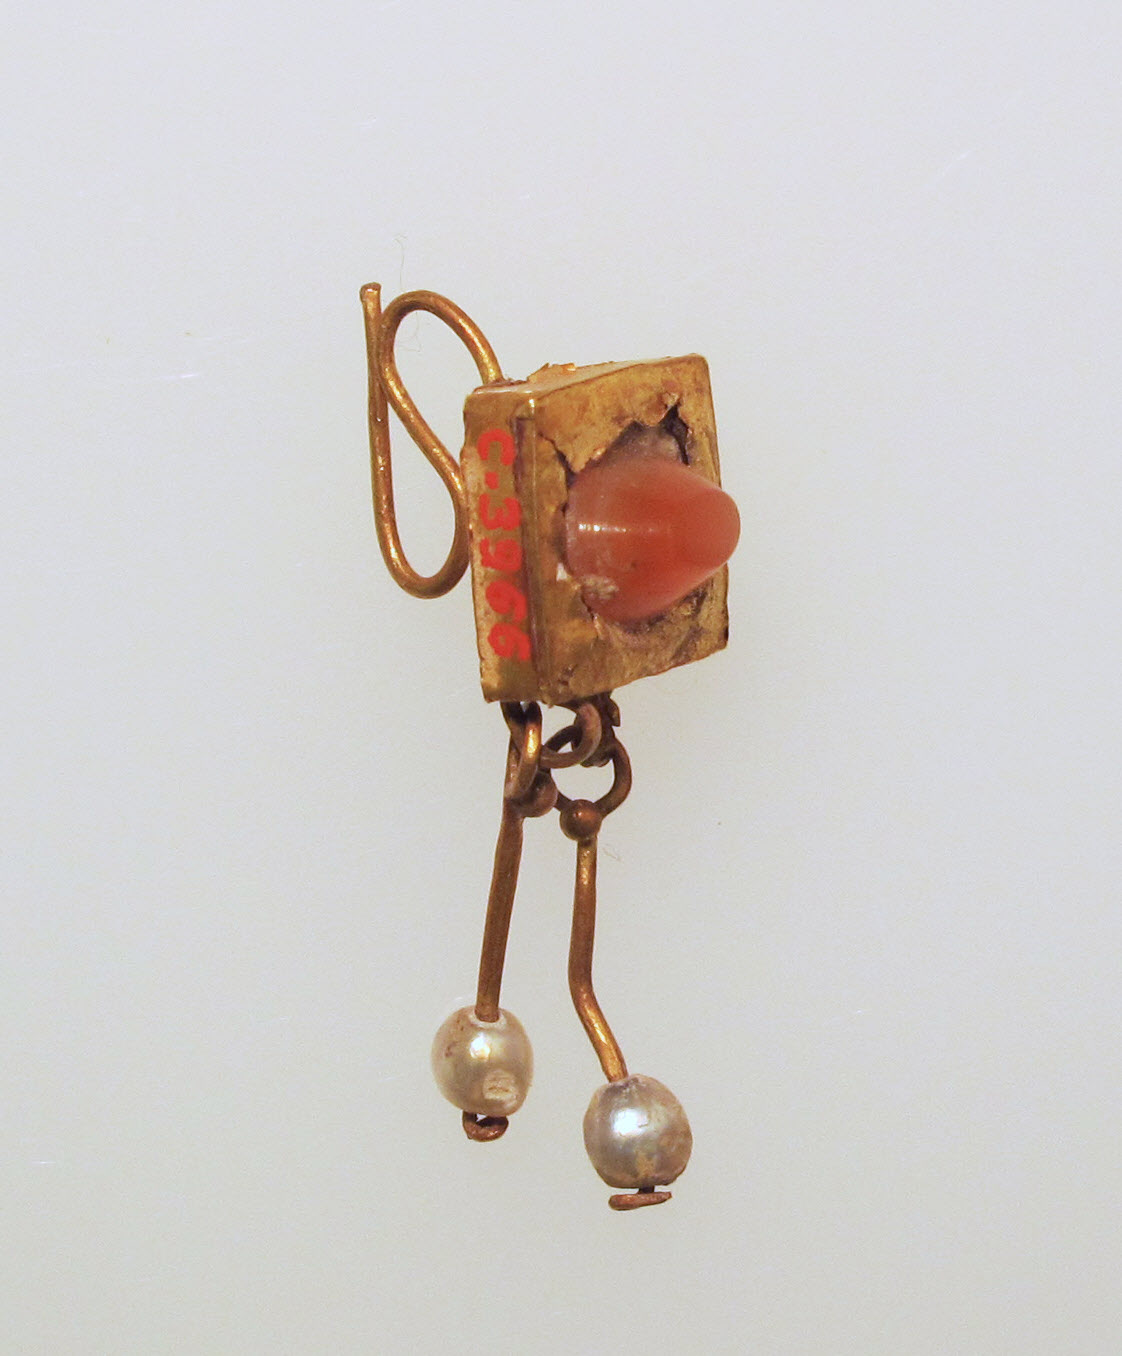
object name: earring hook type with pendant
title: Earring-hook type with pendants of pearls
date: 7000 BCE-330 CE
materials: stone, gold, pearl